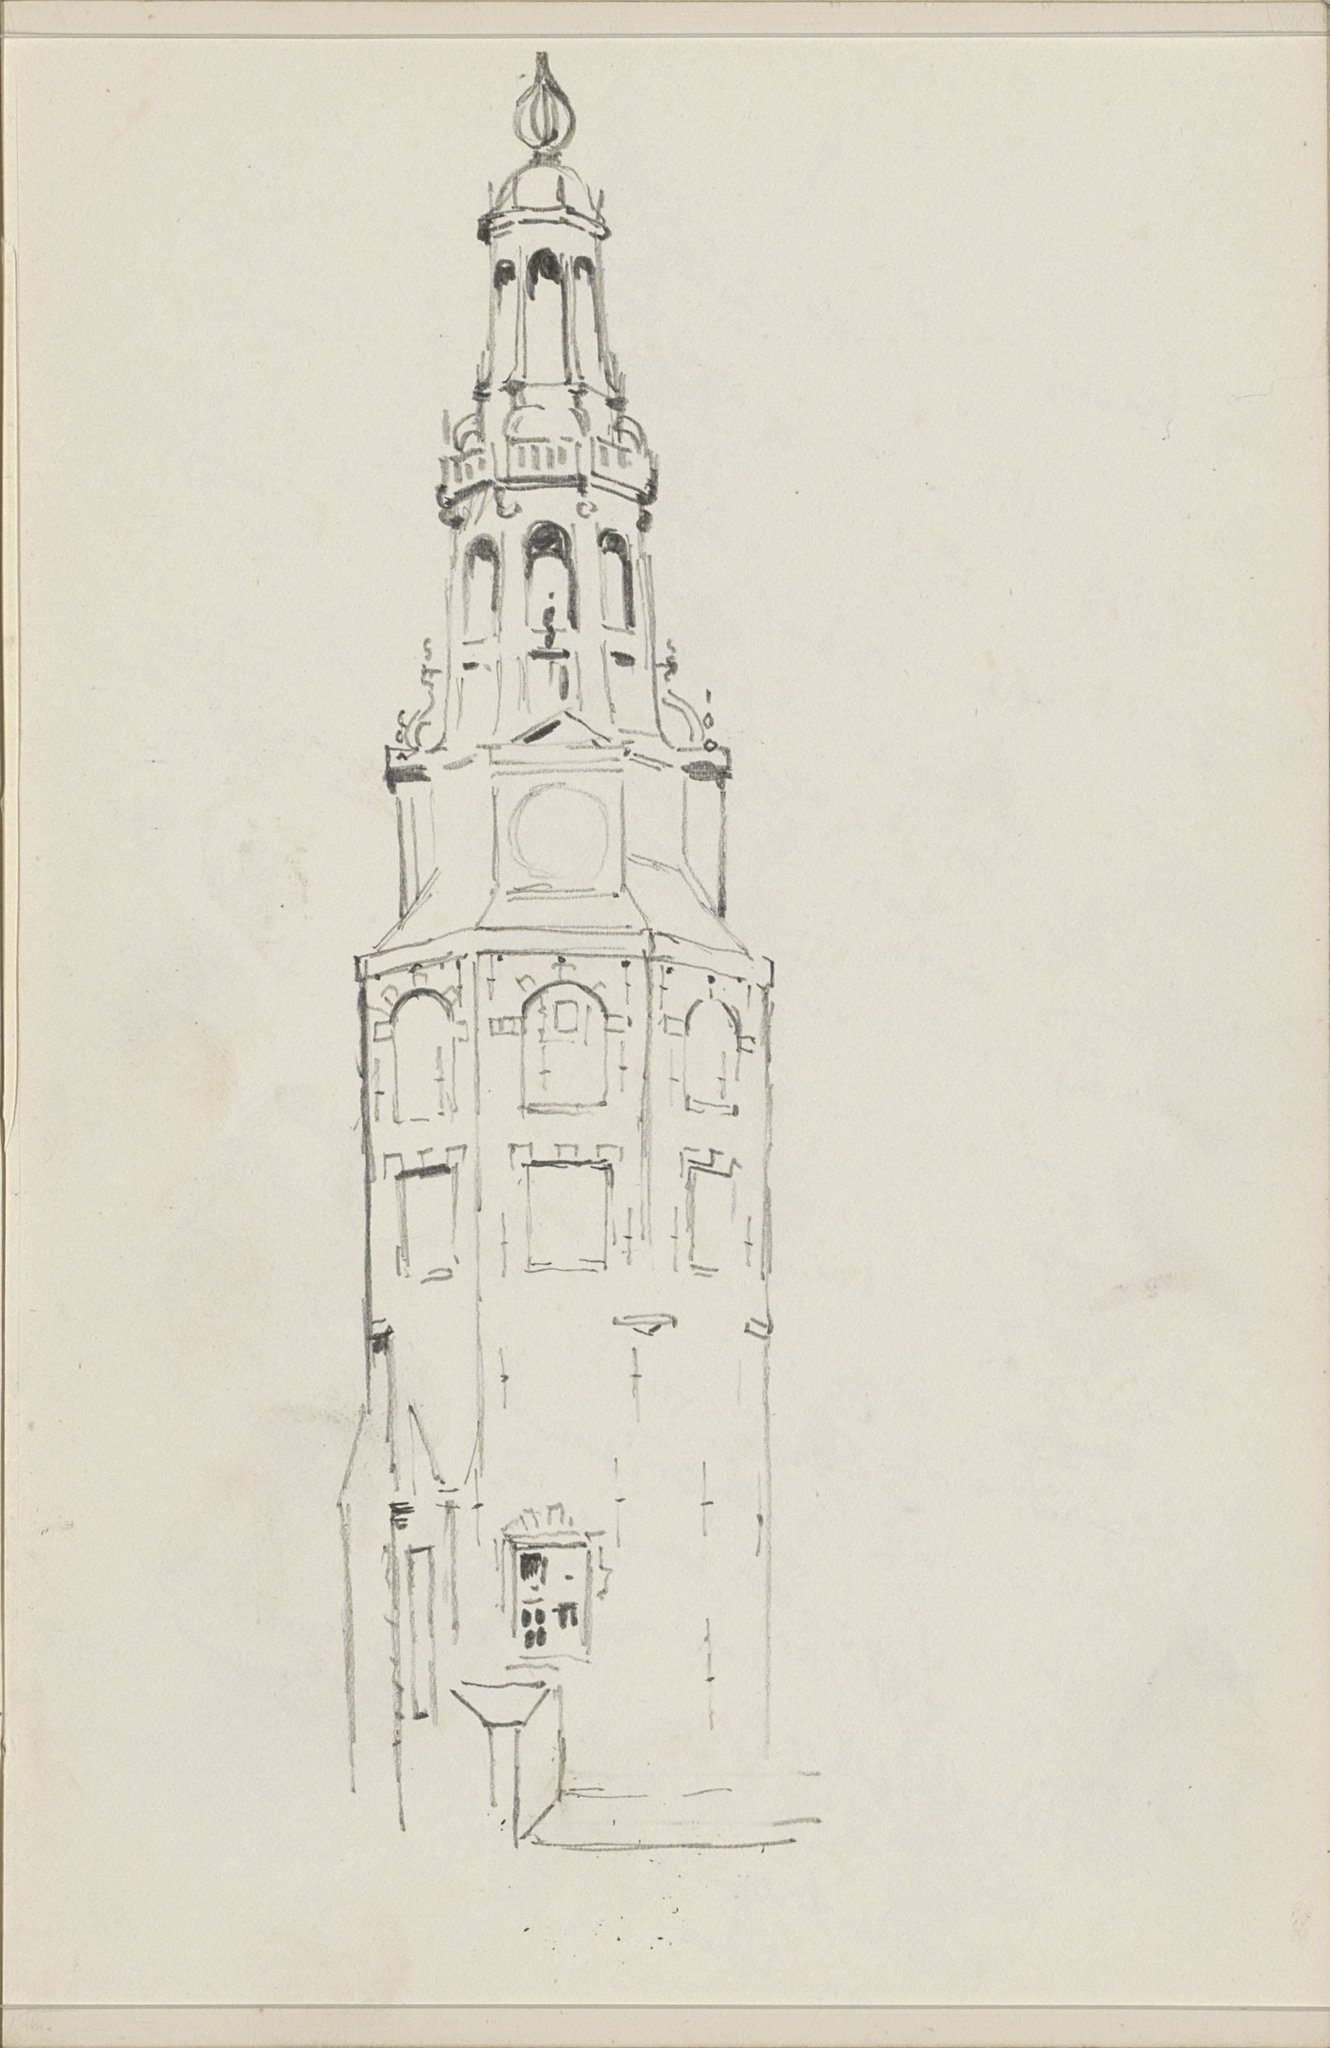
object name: sketchbook leaf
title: Montelbaanstoren te Amsterdam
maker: cornelis vreedenburgh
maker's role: draughtsman, print maker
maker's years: 1880-1946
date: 1890-1946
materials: paper, pencil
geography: amsterdam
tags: tower (of house or building)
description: Blad 26 recto uit een schetsboek met 41 bladen.